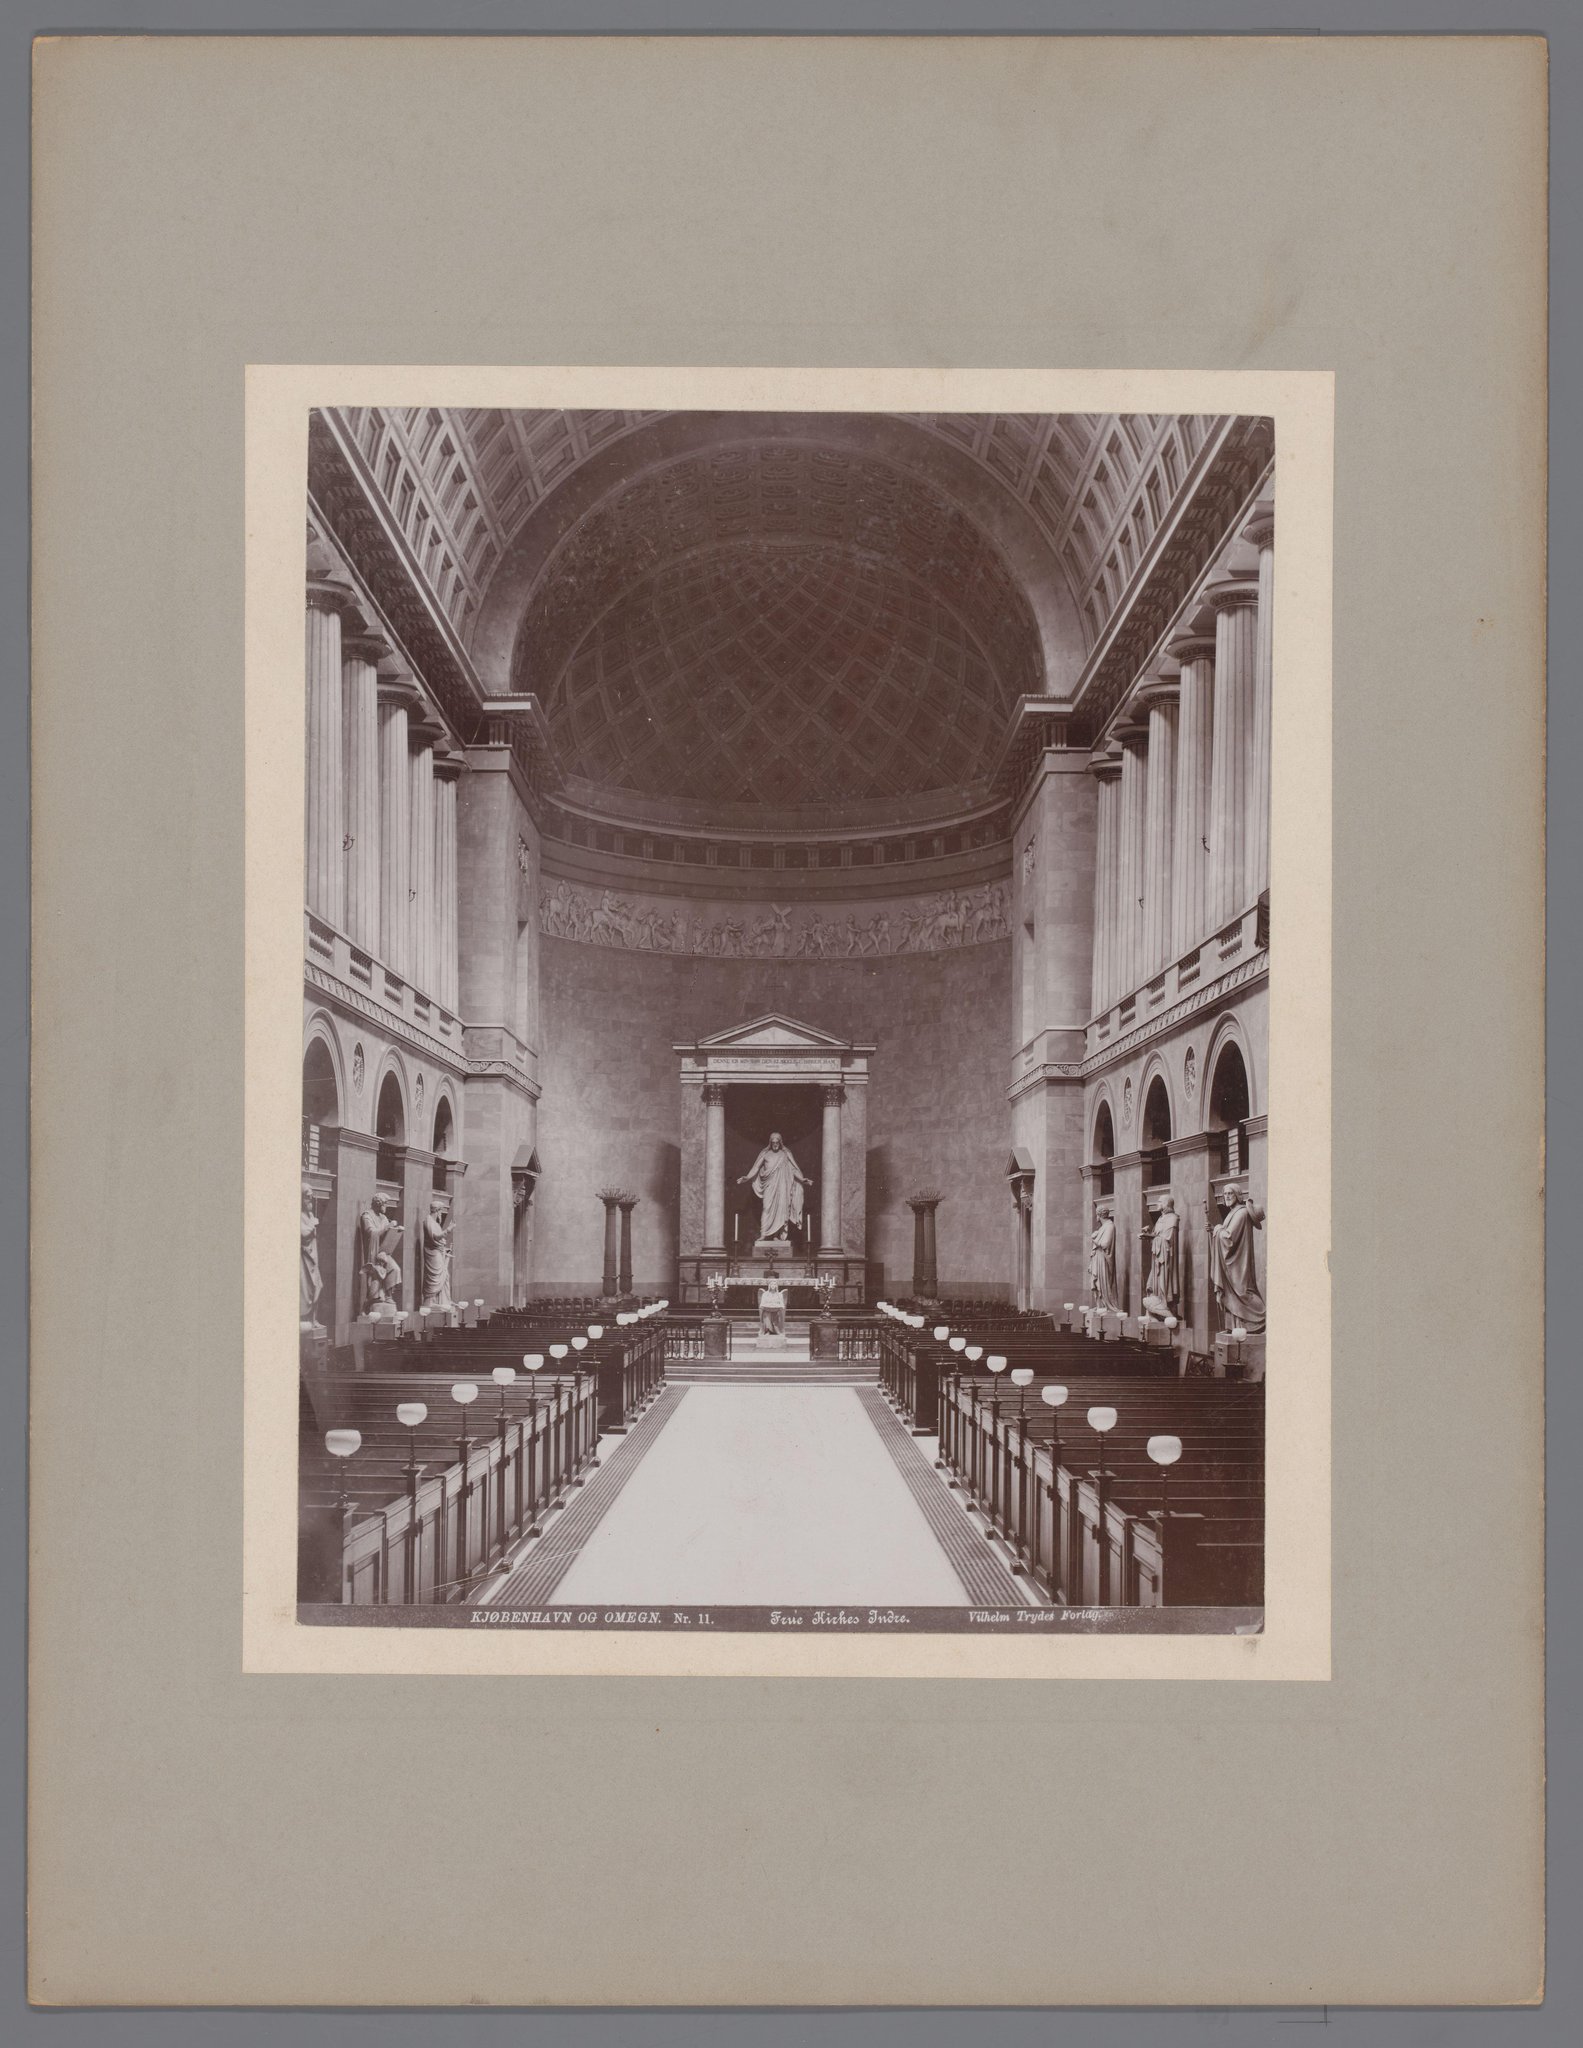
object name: photograph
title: Interieur van de Onze-Lieve-Vrouwekerk in Kopenhagen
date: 1880-1910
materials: paper, cardboard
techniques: collodion silver print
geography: denmark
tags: interior of church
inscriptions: number: ‘Nr. 11.’